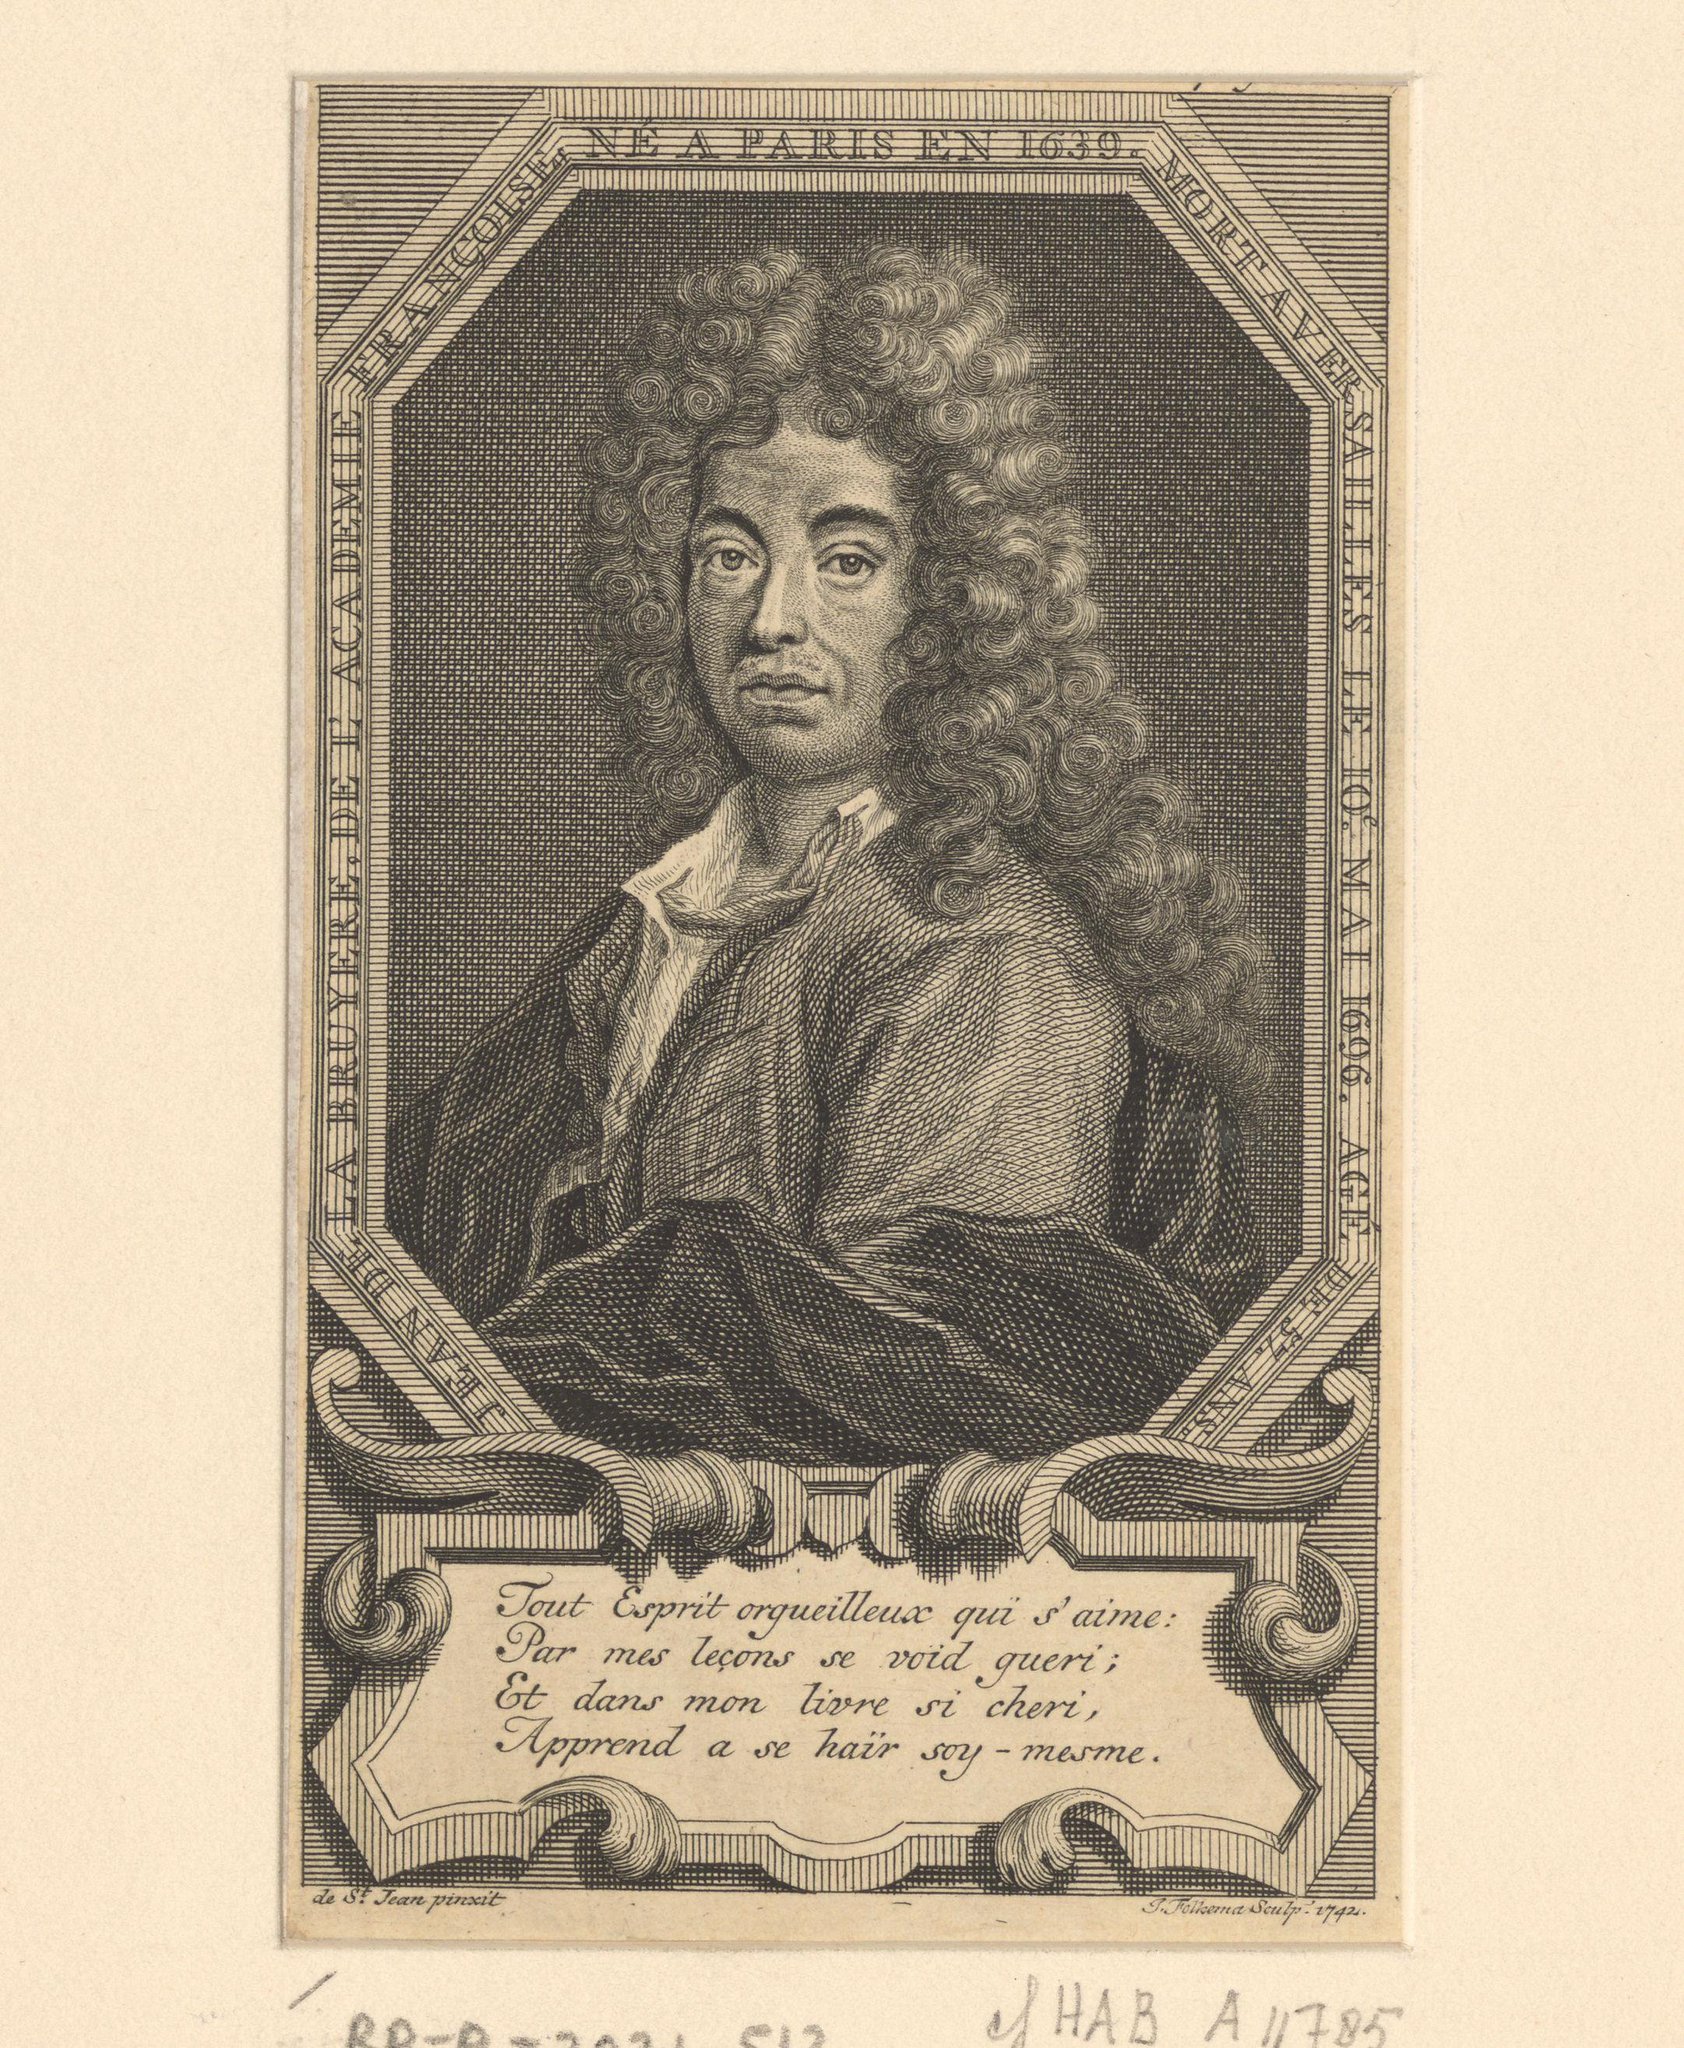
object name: print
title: Portret van Jean de La Bruyère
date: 1742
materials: paper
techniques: engraving, etching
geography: amsterdam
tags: paris, historical persons, portrait of a writer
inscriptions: date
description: Met vierregelig vers in het Frans onder het portret.